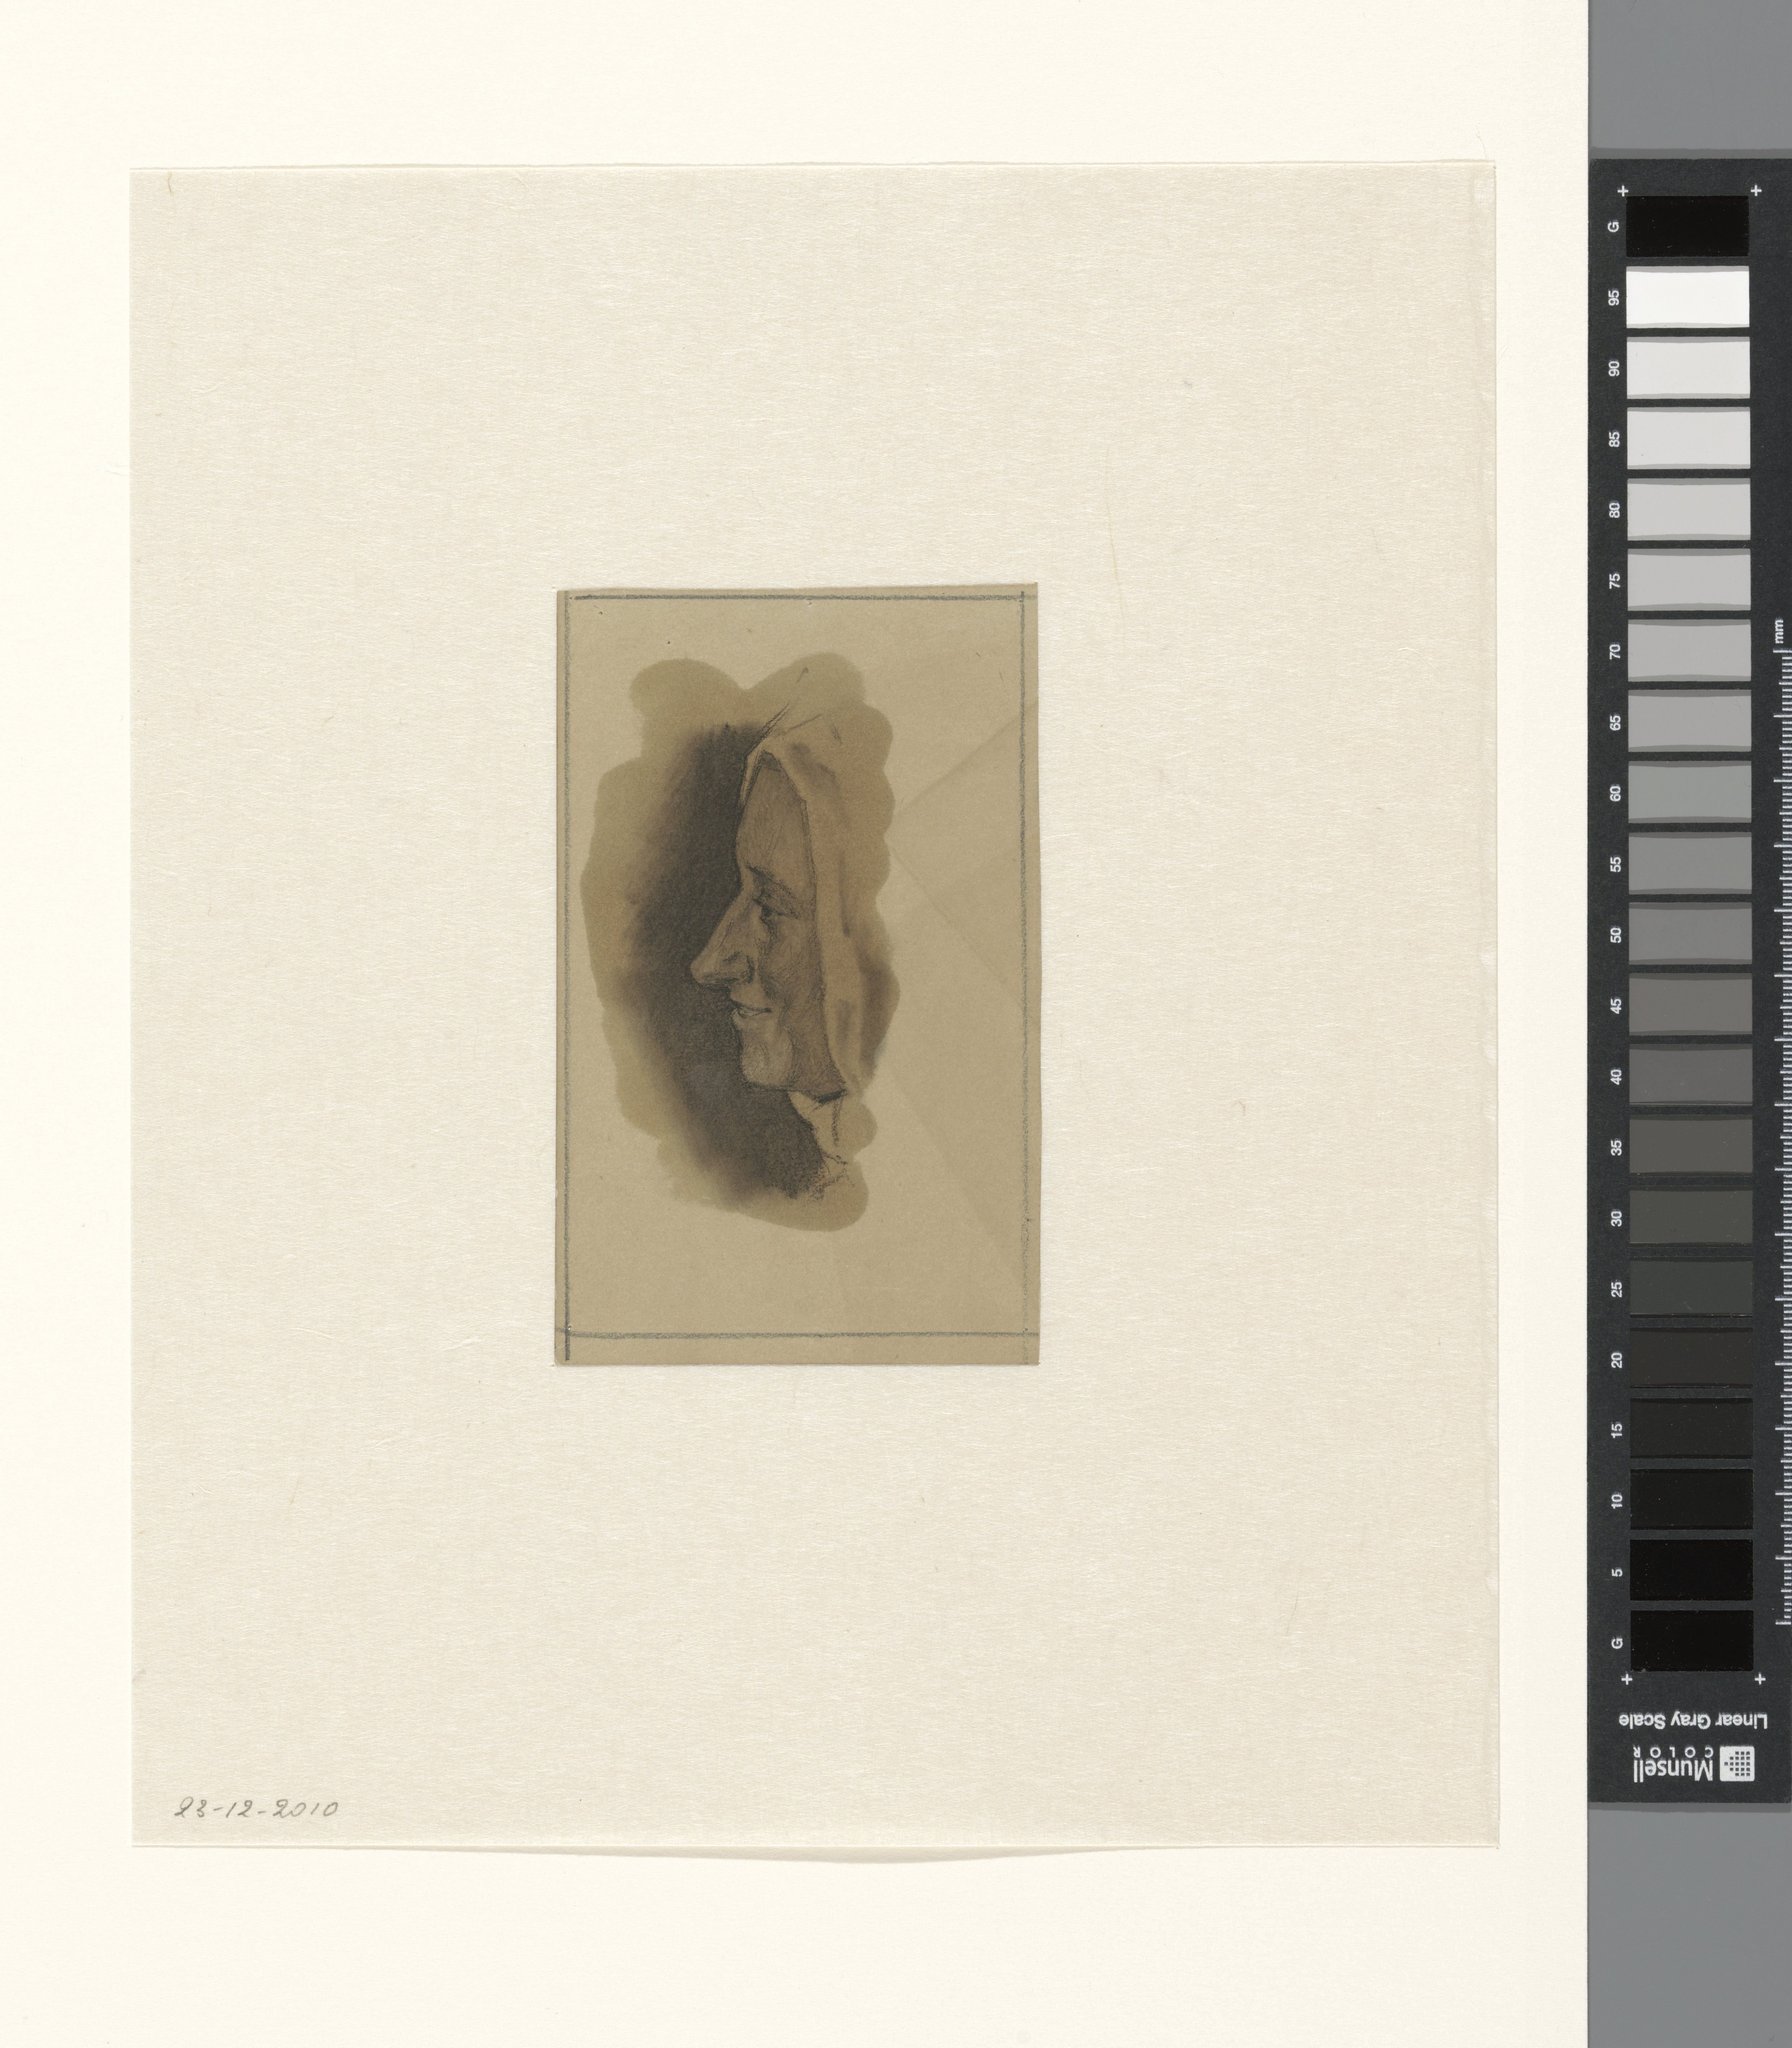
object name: drawing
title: Profiel van een lachende vrouw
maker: jan veth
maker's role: designer, draughtsman, painter, print maker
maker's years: 1864-1925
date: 1874-1925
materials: chalk, paper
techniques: brush